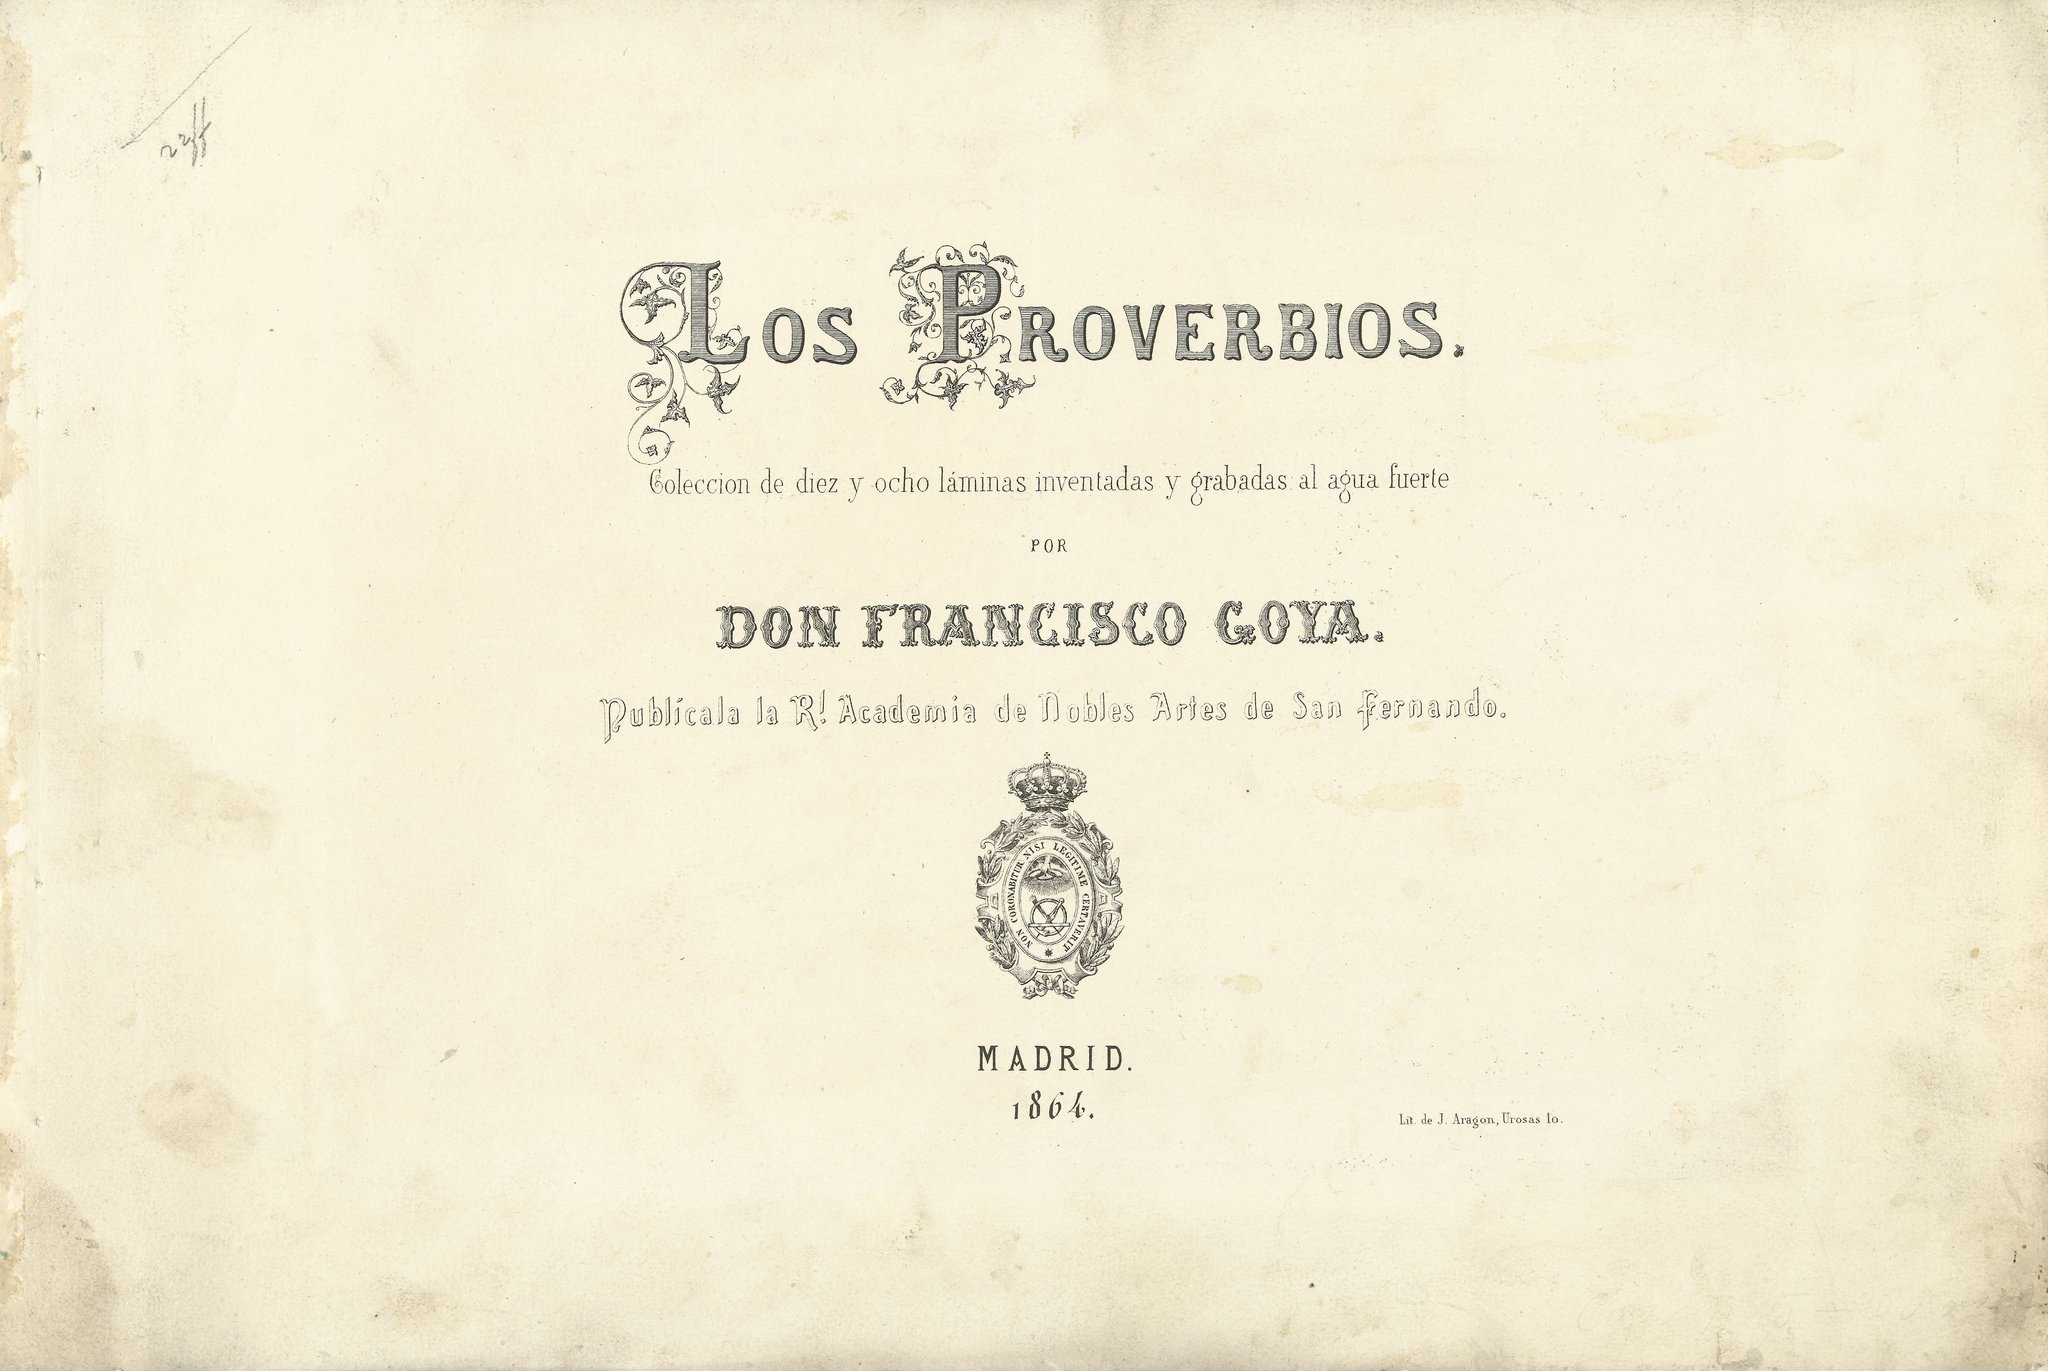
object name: text sheet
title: Titelblad voor de serie "Los Proverbios"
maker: j. aragon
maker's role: printer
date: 1864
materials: paper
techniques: lithograph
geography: madrid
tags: title-page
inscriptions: inscription: ‘Los Proverbios Coleccion de diez y ocho láminas inventadas y grabadas al agua fuerte por Don Franscisco Goya’, collector's mark: Lugt 2228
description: De serie Los Disparates is pas na de dood van Goya uitgegeven. De Real Academia des Nobles Artes heeft de serie gepubliceerd in 1864 onder de naam Los Proverbios. Harris heeft in zijn catalogus aan elke prent een Spaans spreekwoord toegekend, maar Pérez Sanchéz en Gallego zijn van de juistheid hiervan niet overtuigd. K.Botke